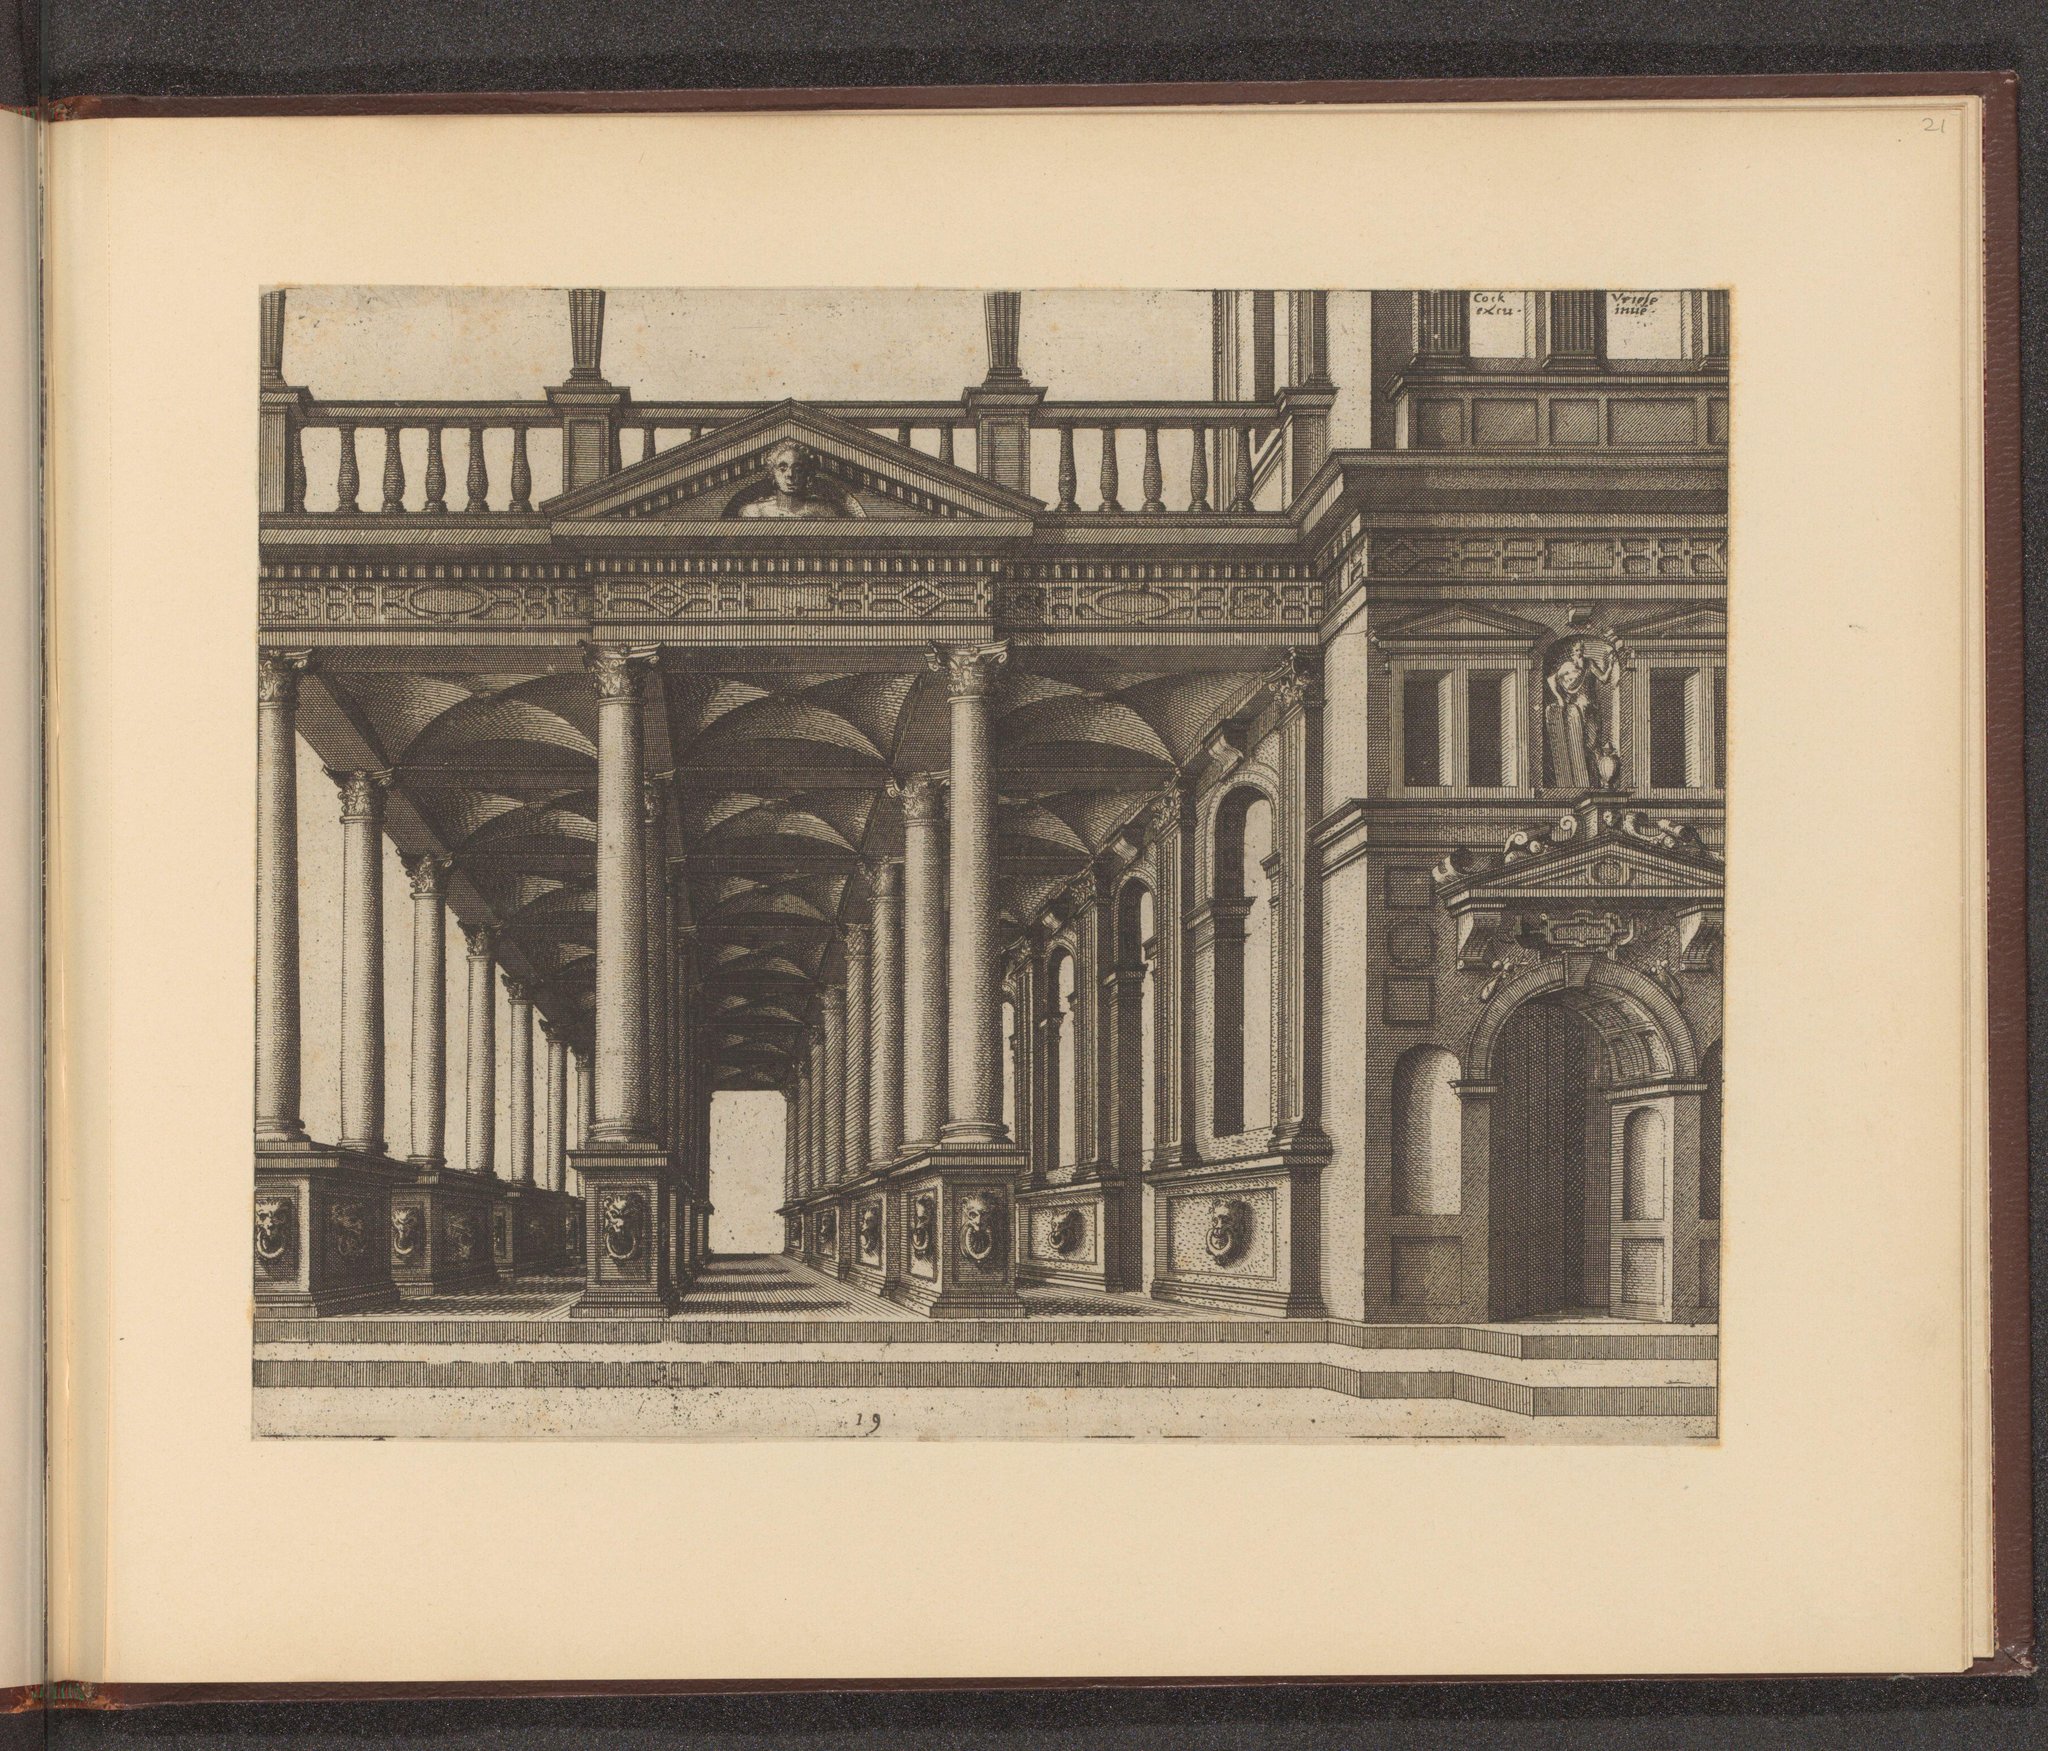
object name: album leaf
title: Open hal met zuilen van de Korintische orde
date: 1563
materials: paper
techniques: etching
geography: antwerp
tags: column, pillar ~ architecture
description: Open hal met zuilen van de Korintische orde op piëdestallen. Rechts een gebouw met fronton boven de deur. Daarboven een beeld van Mozes met de tafelen der wet. Prent maakt deel uit van een album.